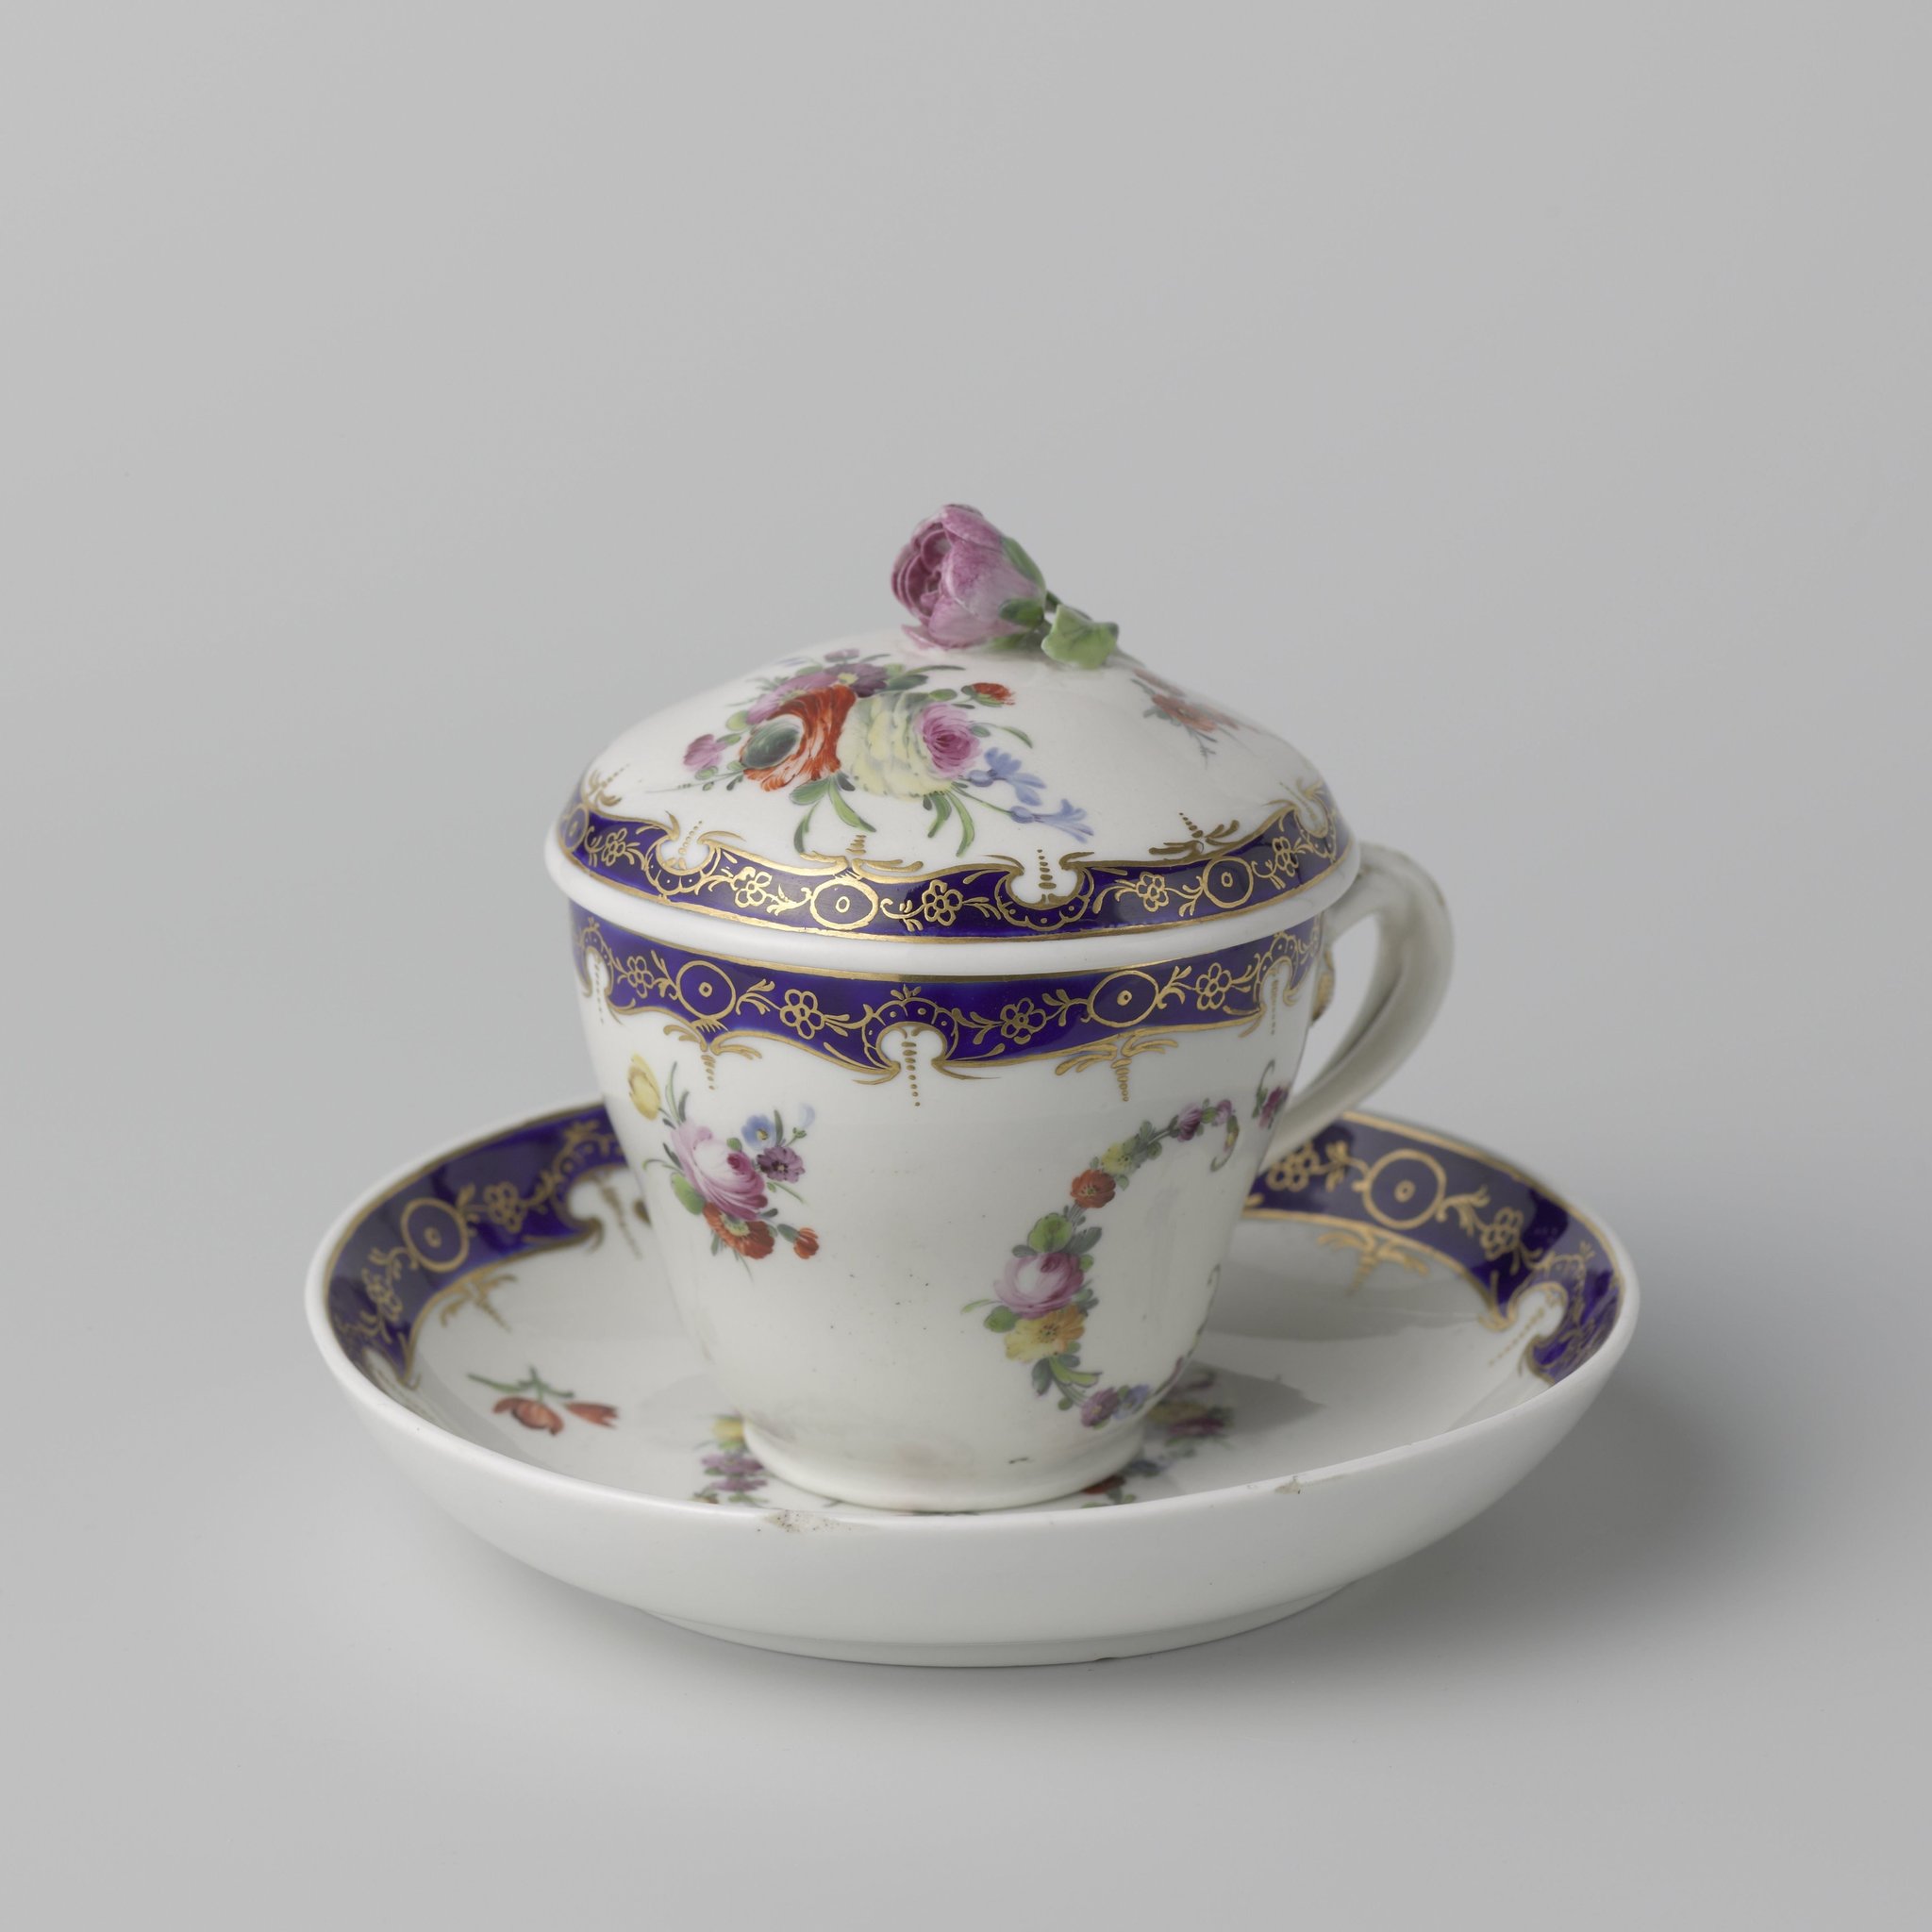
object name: vessel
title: Chocolate cup and saucer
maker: Anonymous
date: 1785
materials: porcelain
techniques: painted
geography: the hague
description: Tournai painted decoration: Porseleinfabriek Den Haag, 1785 soft-paste porcelain (pâte-tendre)